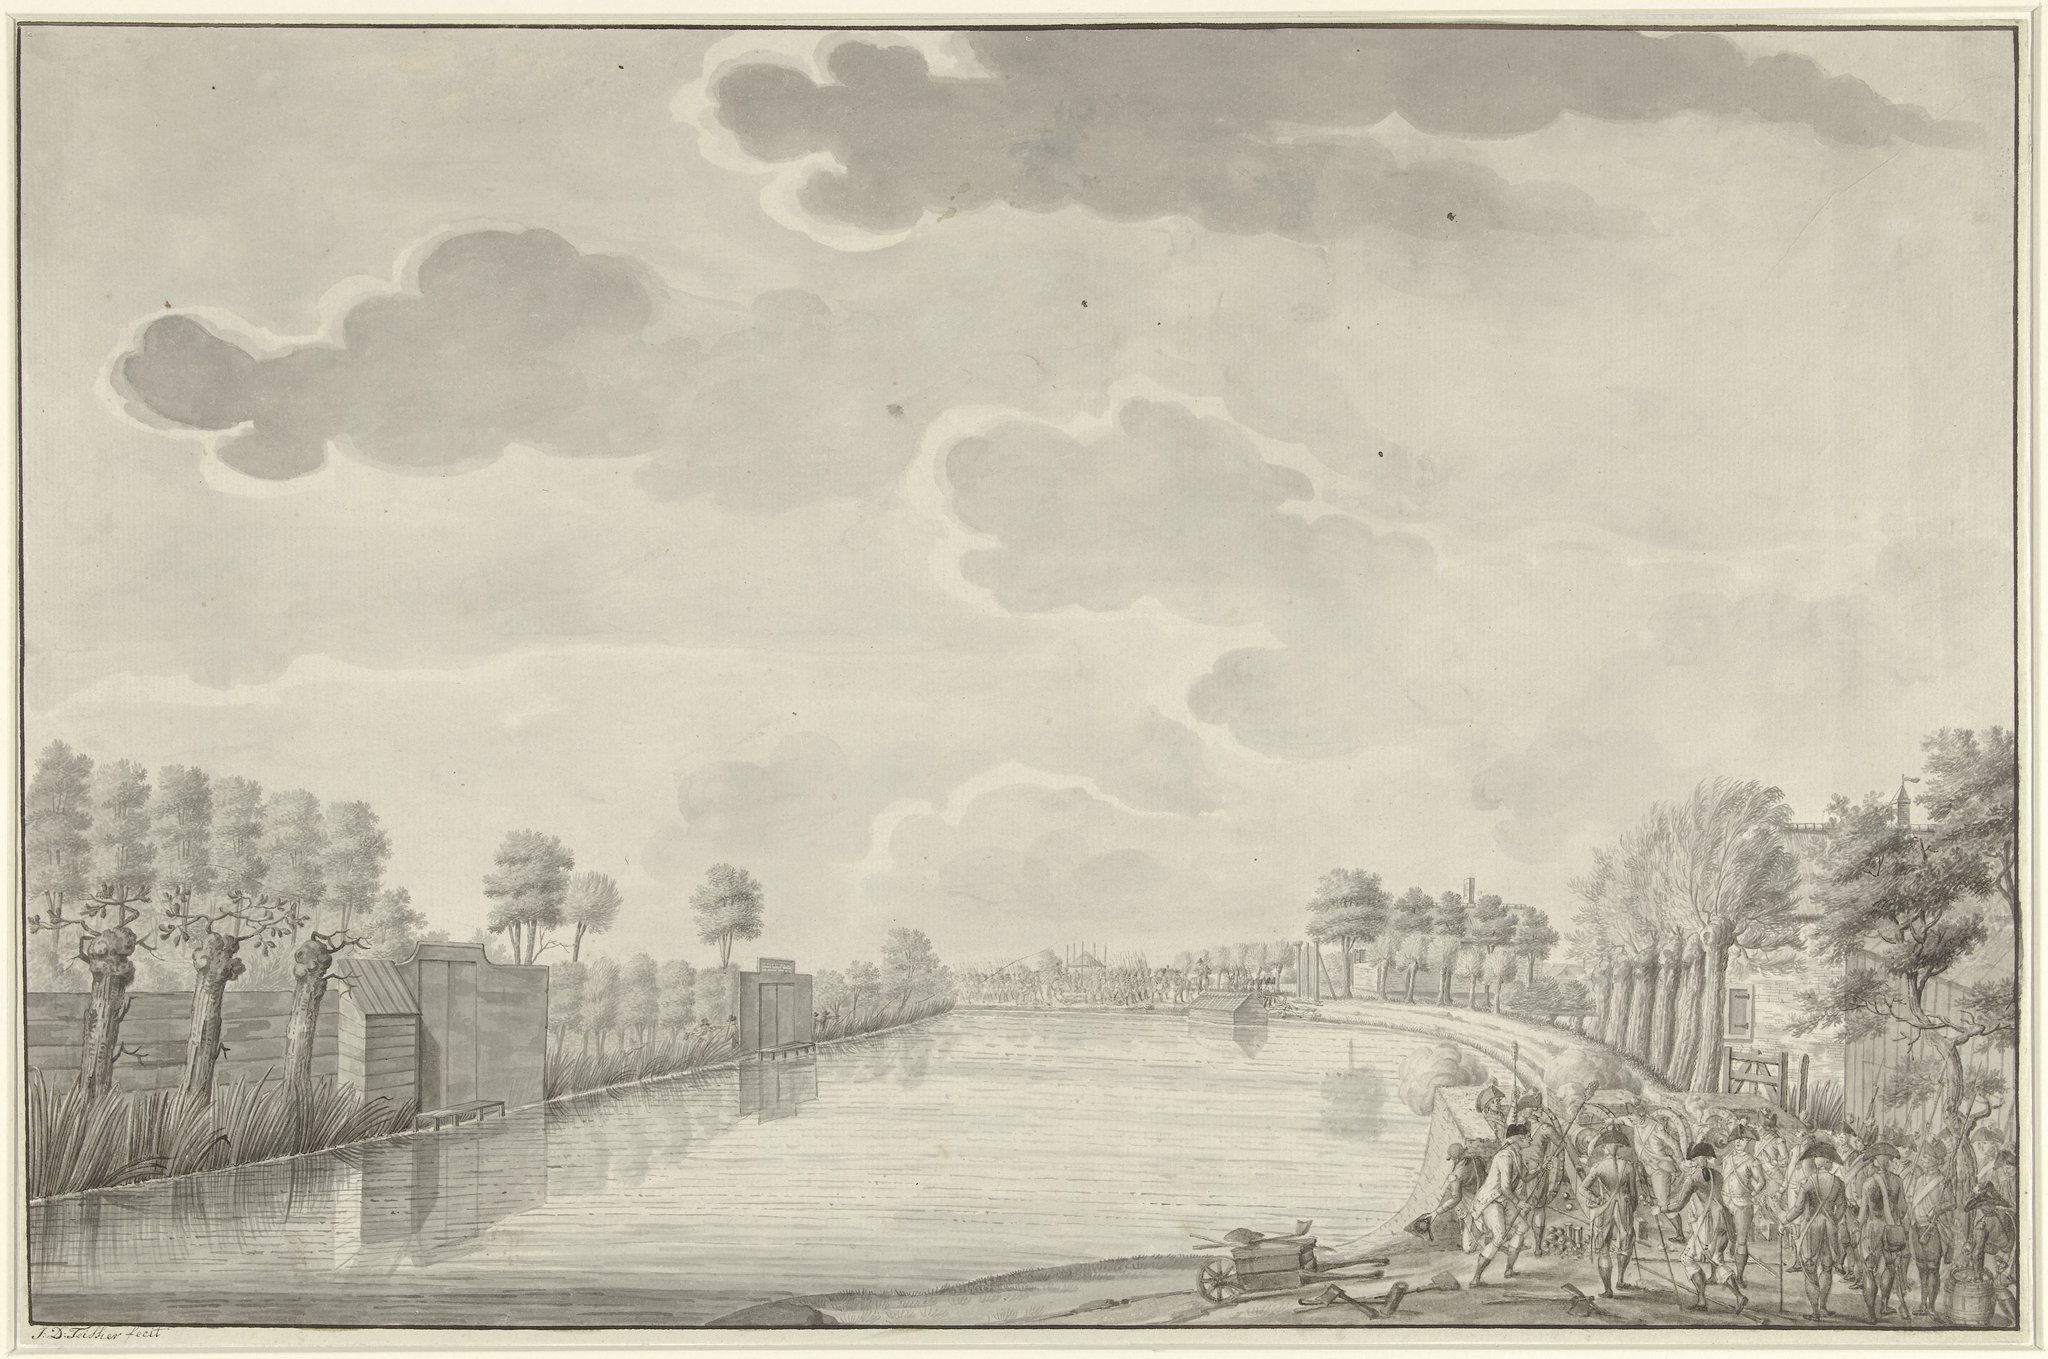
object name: drawing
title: Aanval bij Ouderkerk aan de Amstel bij de Binnen-Bullewijk, 1787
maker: jean george teissier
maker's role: draughtsman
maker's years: 1749-1821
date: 1788-1790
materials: ink, paper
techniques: brush, pen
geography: northern netherlands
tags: (military) attack, war, battle (+ land forces)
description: Aanval bij de Bullewijk bij de Joodse begraafplaats in Ouderkerk aan de Amstel door de Pruisische troepen onder commando van generaal Friedrich Adolf von Kalckreuth, verdedigd door Amsterdamse schutters onder commando van kolonel George Hendrik de Wilde, 1 oktober 1787. Ontwerp voor een prent.